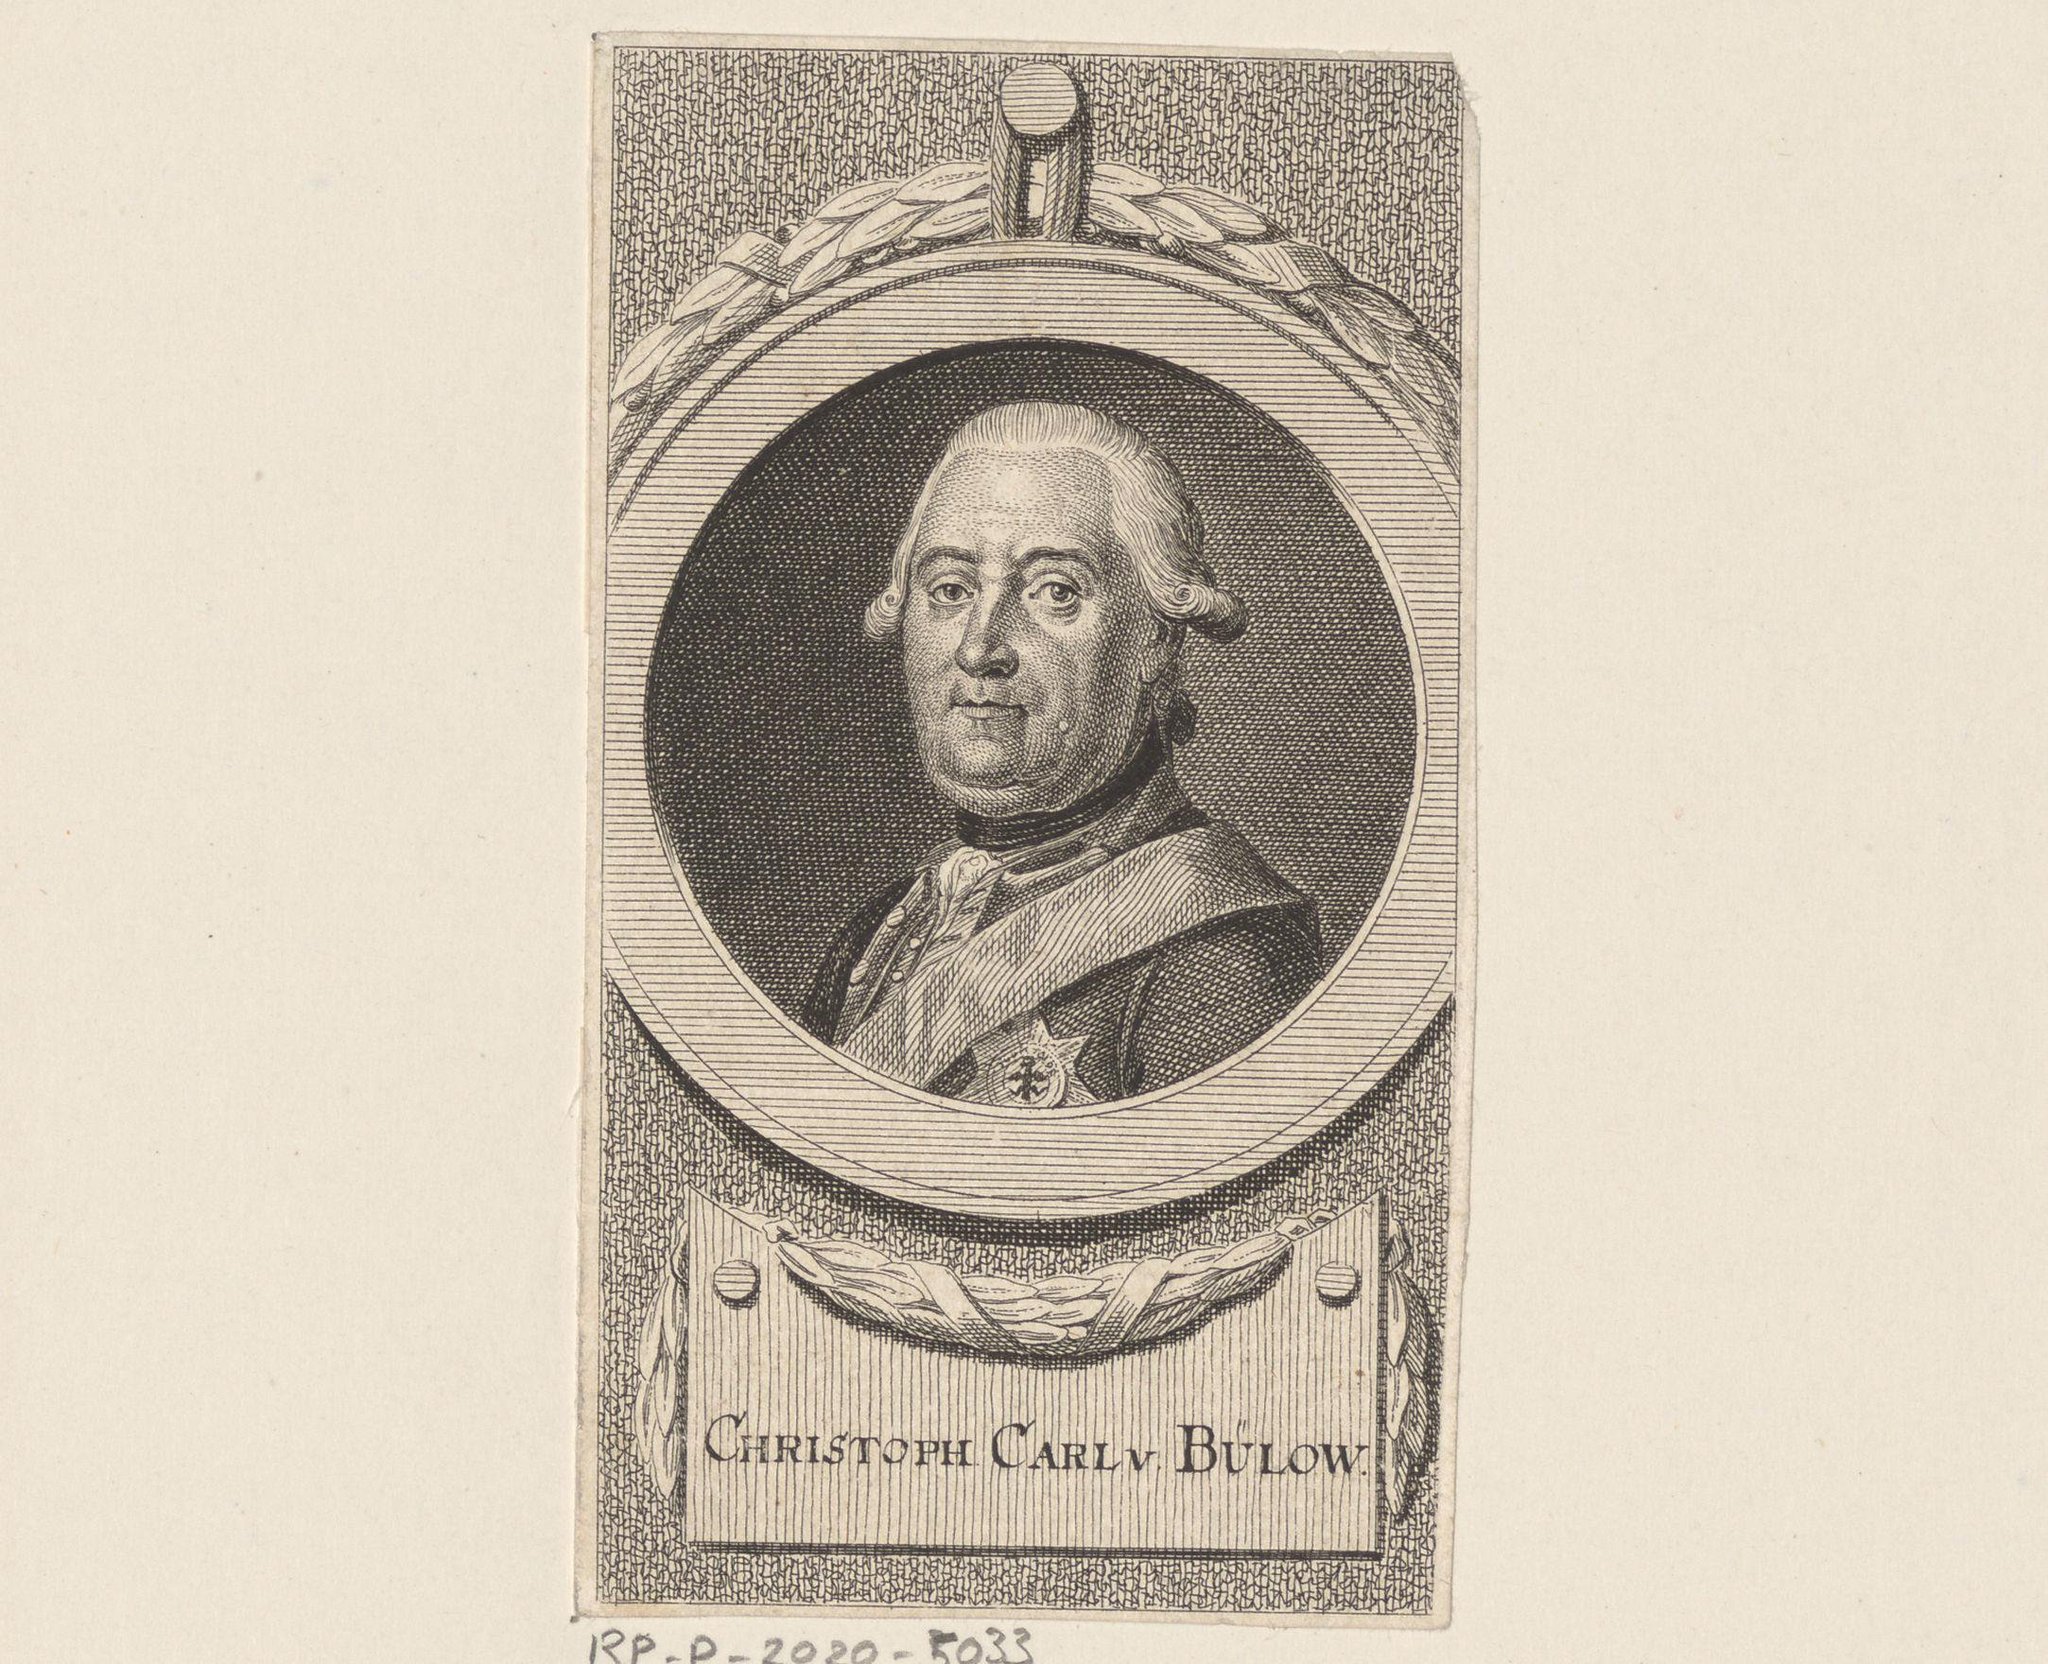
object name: print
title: Portret van Christoph Carl von Bülow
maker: daniel berger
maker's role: print maker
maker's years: 1744-1824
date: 1754-1799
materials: paper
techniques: engraving, etching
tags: commander-in-chief, general, marshal, historical persons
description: Oorspronkelijk rechtsboven genummerd: 3 (hier weggesneden).